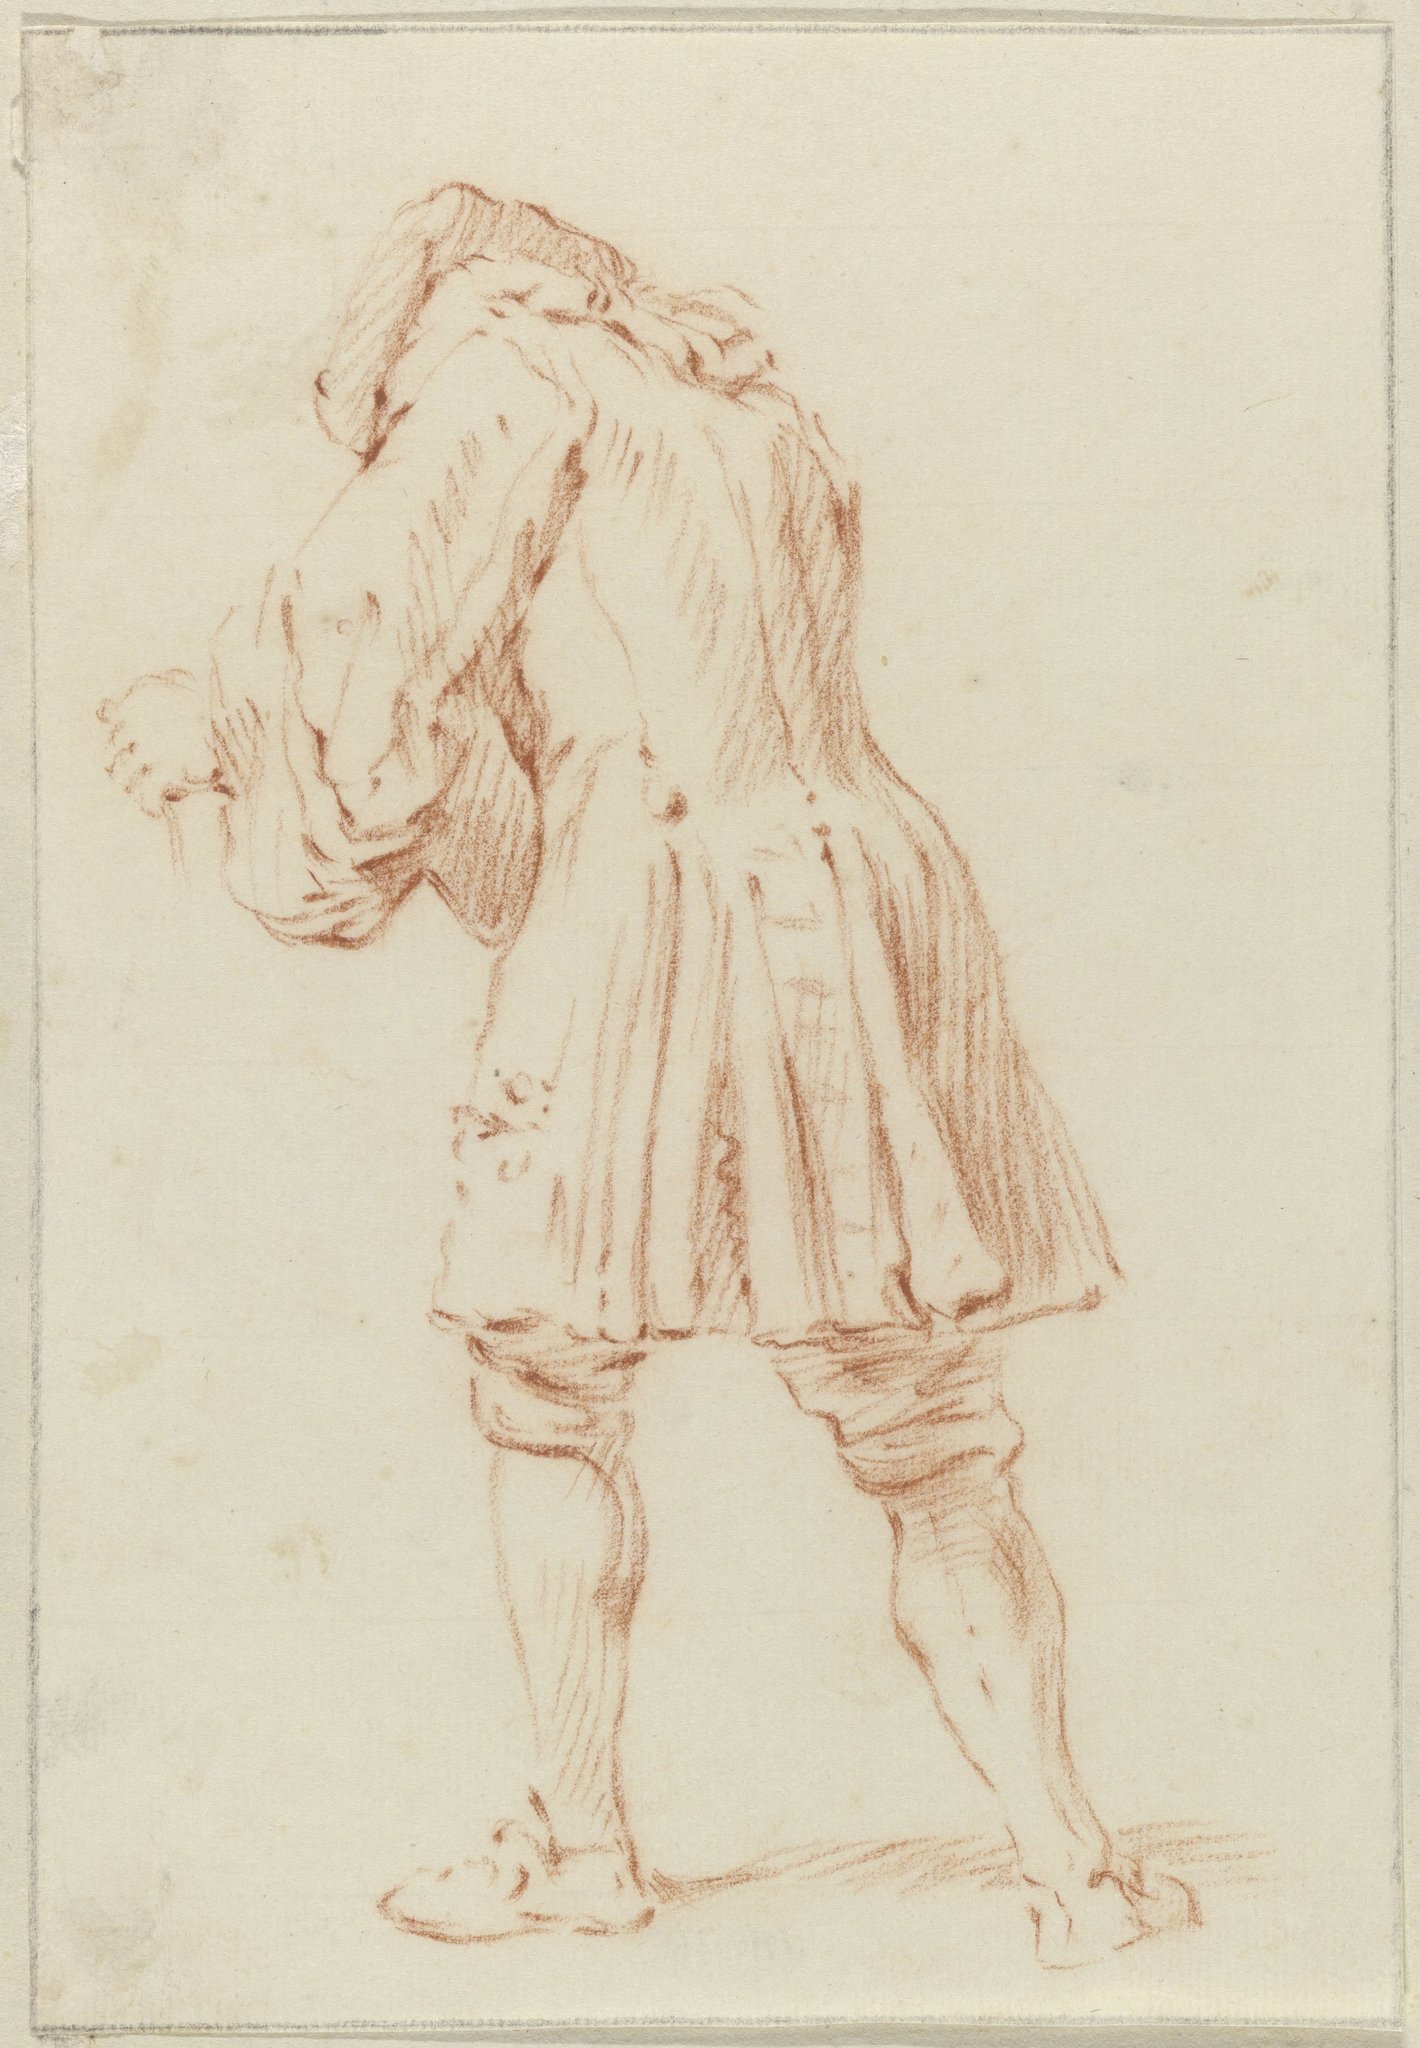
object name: drawing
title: Staande voorover genegen man op de rug gezien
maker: Anonymous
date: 1700-1799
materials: chalk, paper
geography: netherlands